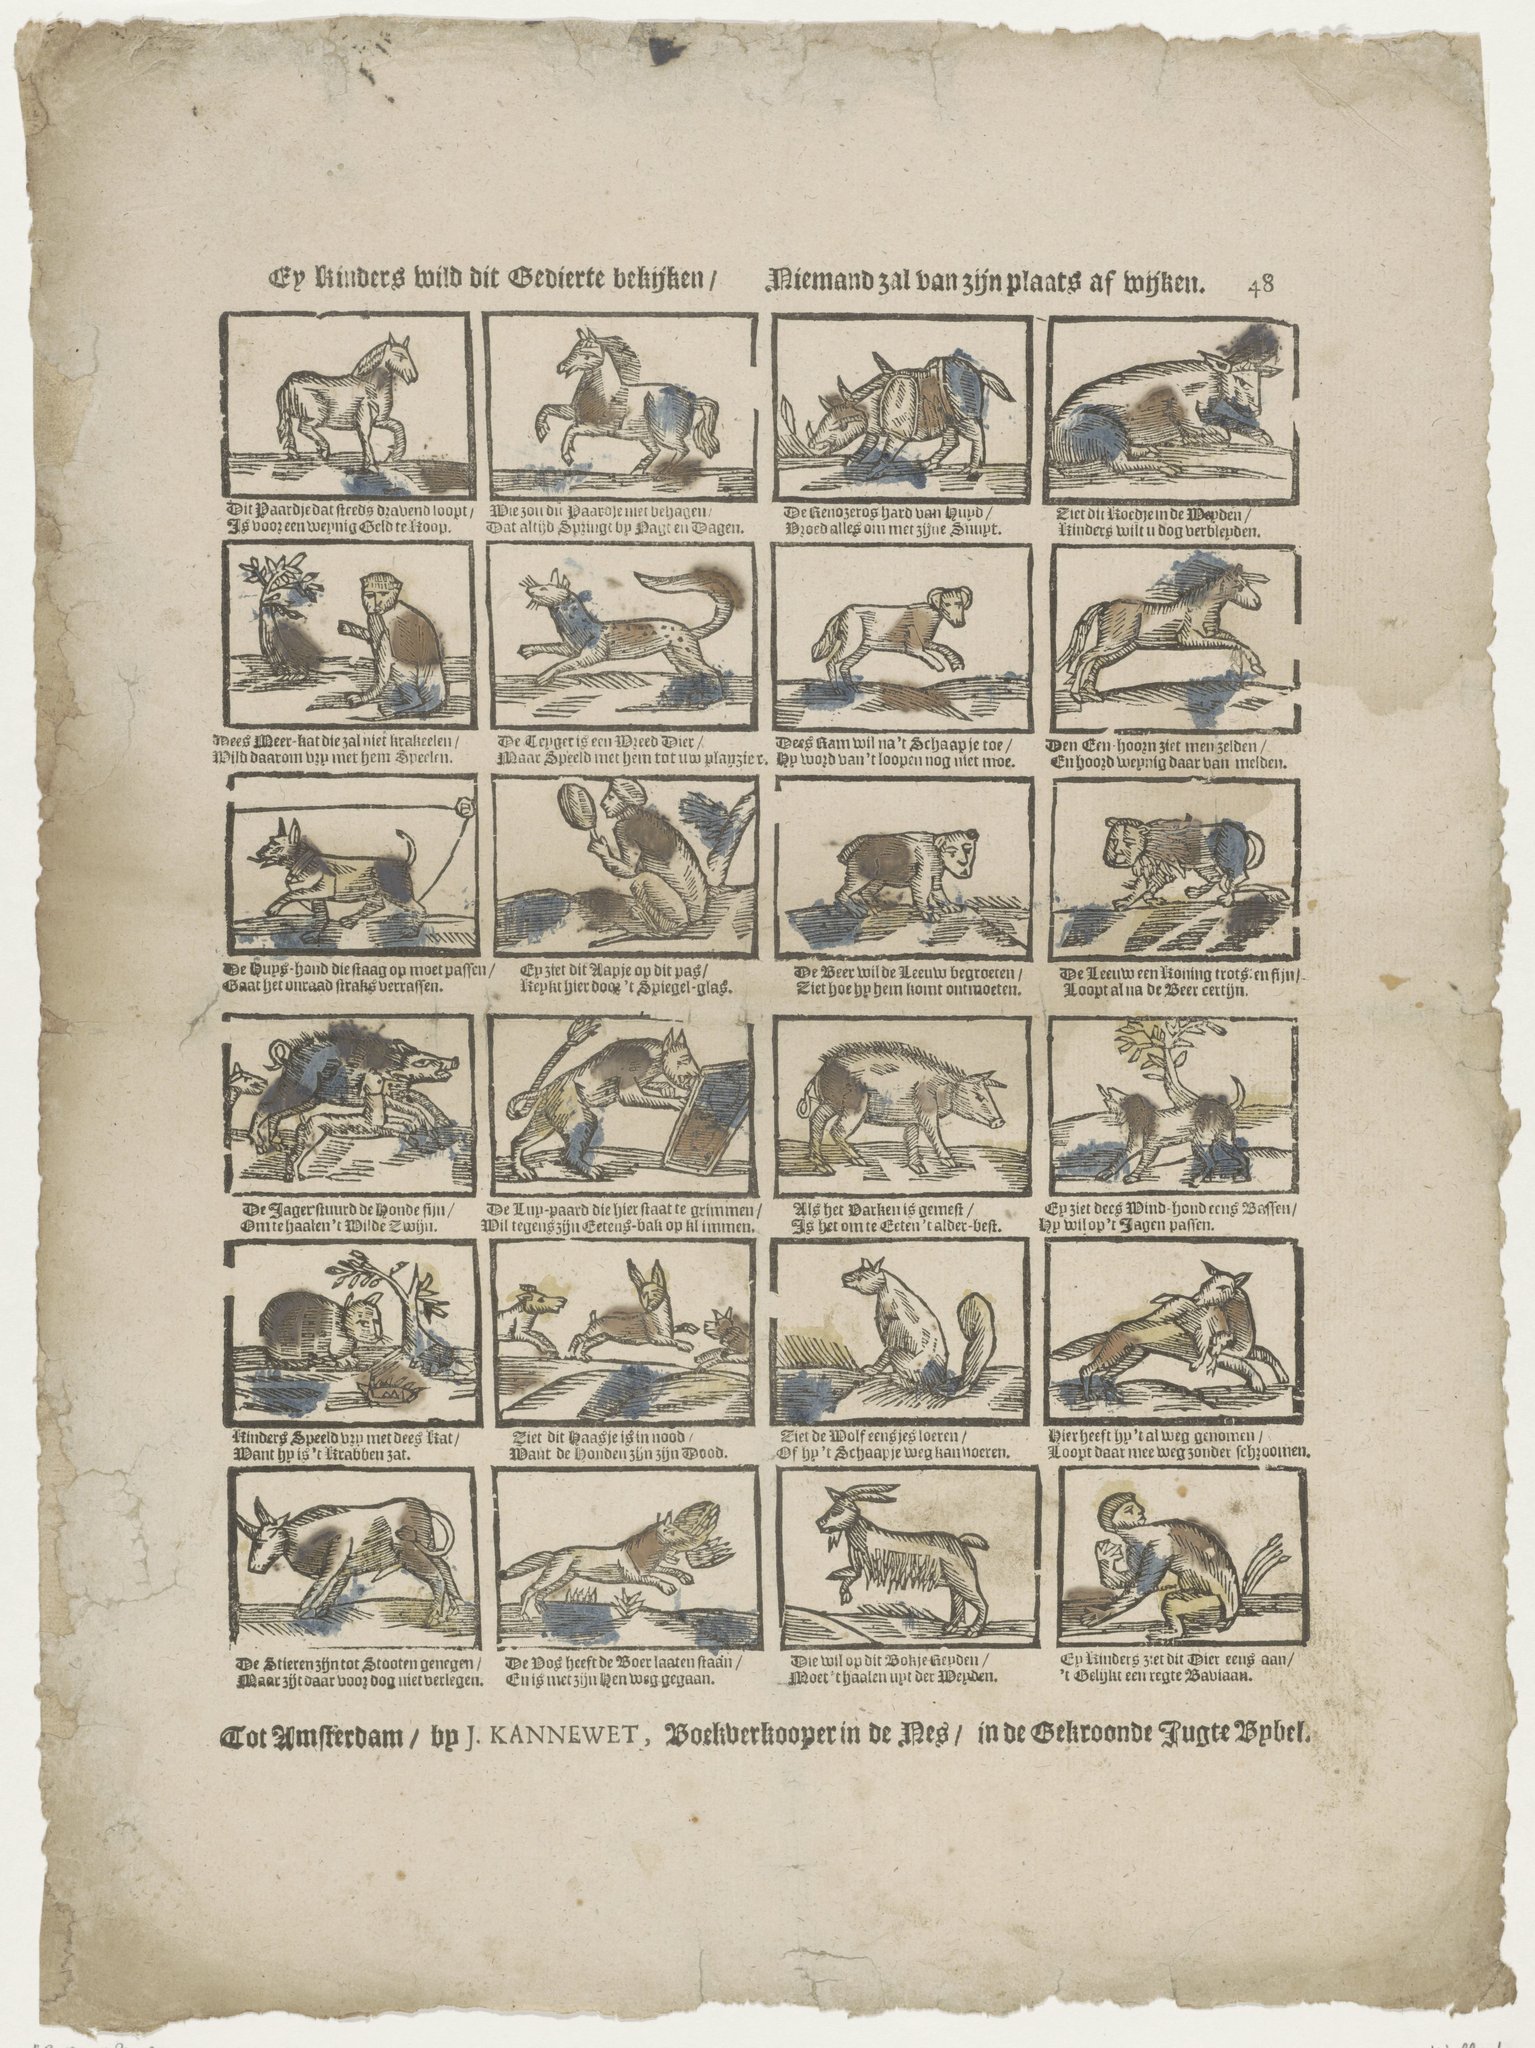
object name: popular print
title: Ey kinders wild dit gedierte bekijken / Niemand zal van zijn plaats af wijken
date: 1725-1780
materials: paper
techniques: colour, letterpress printing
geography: amsterdam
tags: animals, hoofed animals: rhinoceros, horse, dog, beasts of prey, predatory animals: wolf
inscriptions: collector's mark: Lugt 2228, collector's mark: Lugt 2760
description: Blad met 24 voorstellingen van dieren, zoals een paard, een neushoorn, een beer en een wolf. Onder elke afbeelding een tweeregelig vers. Genummerd rechtsboven: 48.